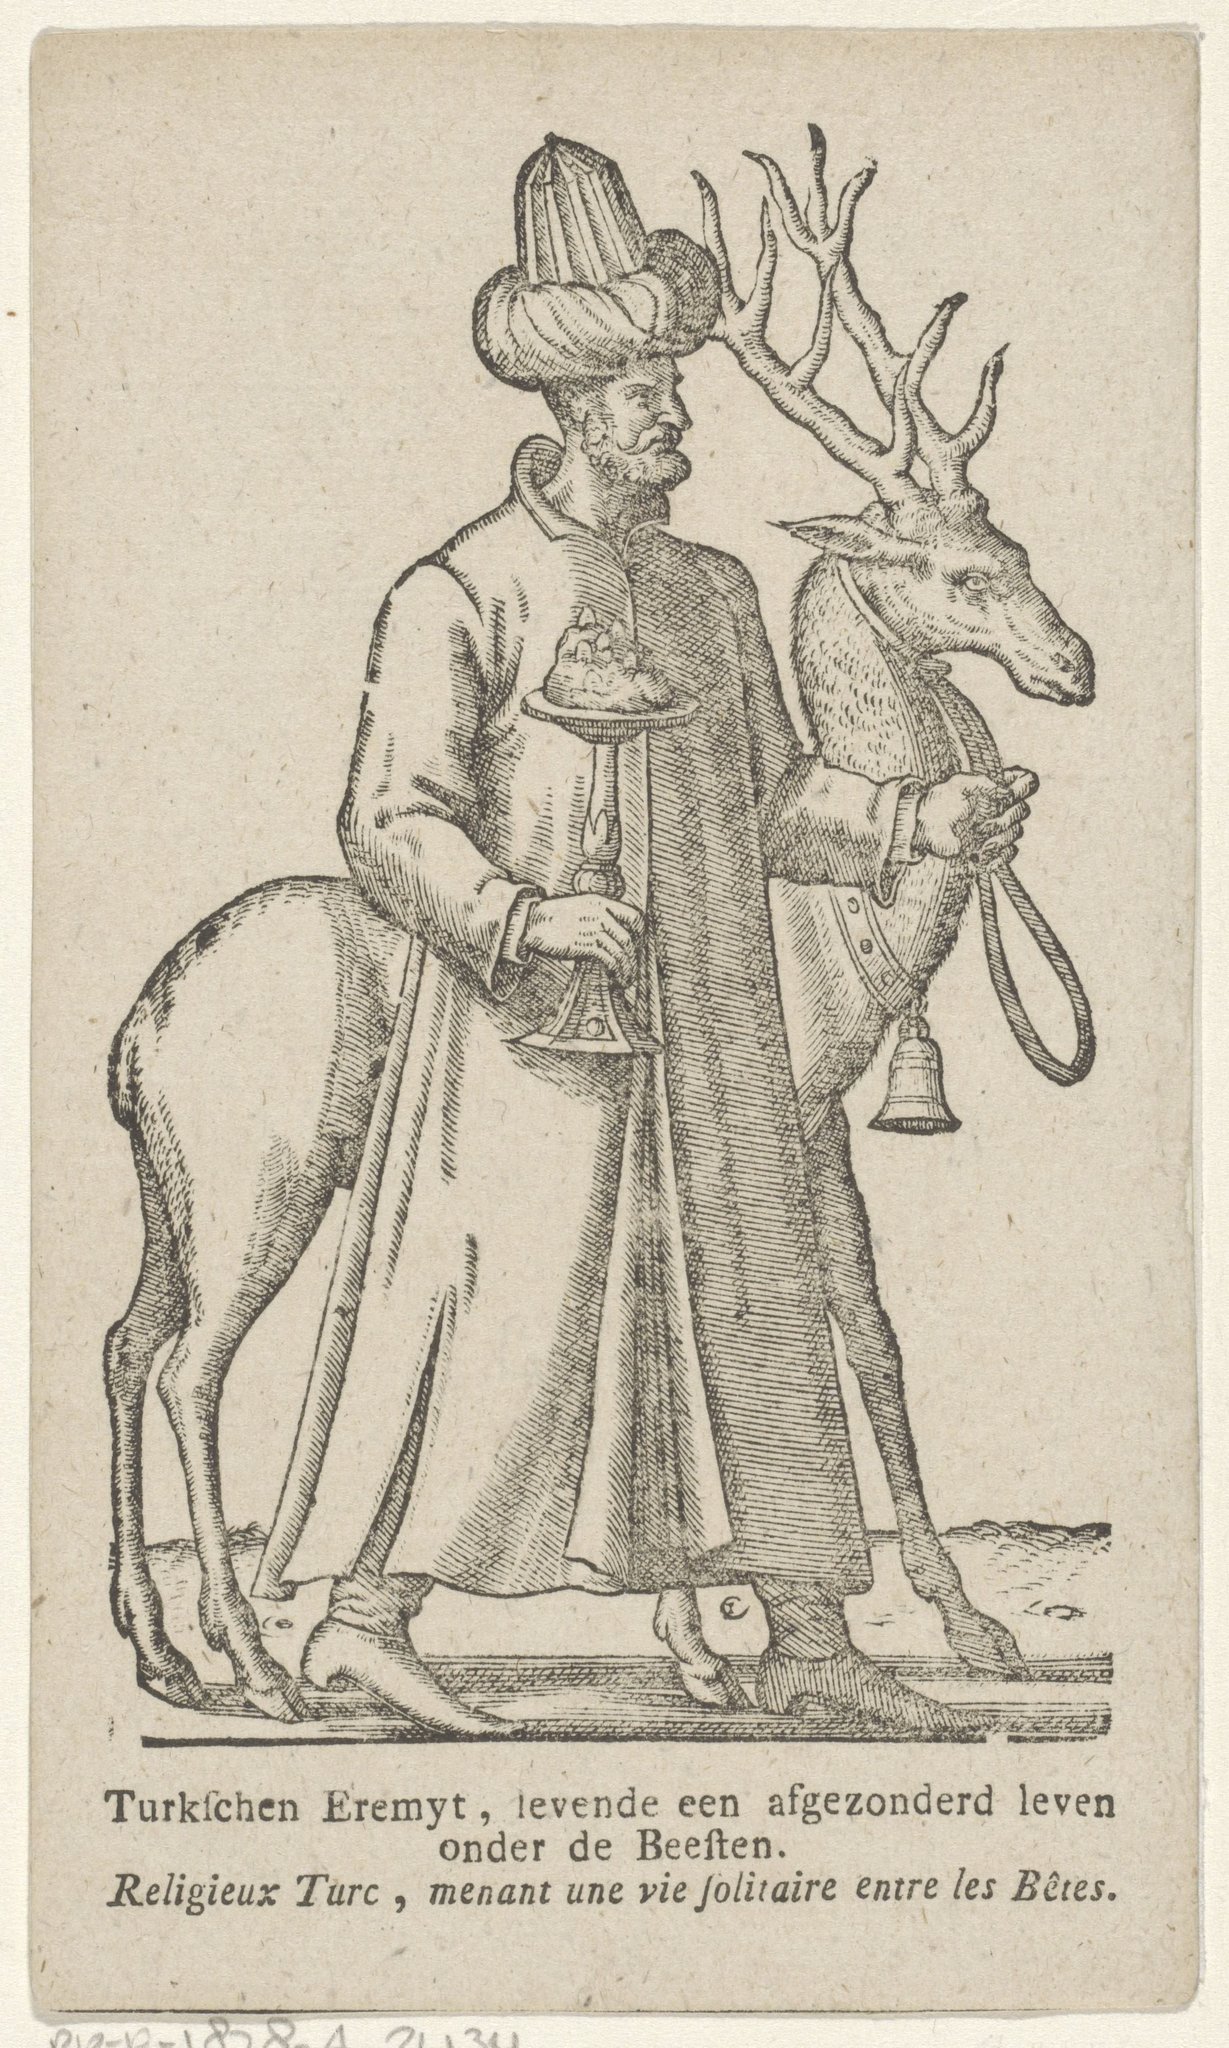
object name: print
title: Turkschen Eremyt, levende een afgezonderd leven onder de Beesten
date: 1576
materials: paper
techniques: letterpress printing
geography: antwerp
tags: hoofed animals: deer, asiatic races and peoples: turks, head-gear: turban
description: Prent uit: Nicolas de Nicolay. Les navigations pérégrinations et voyages faicts à la Turquie. Antwerpen: Willem Silvius, 1576.